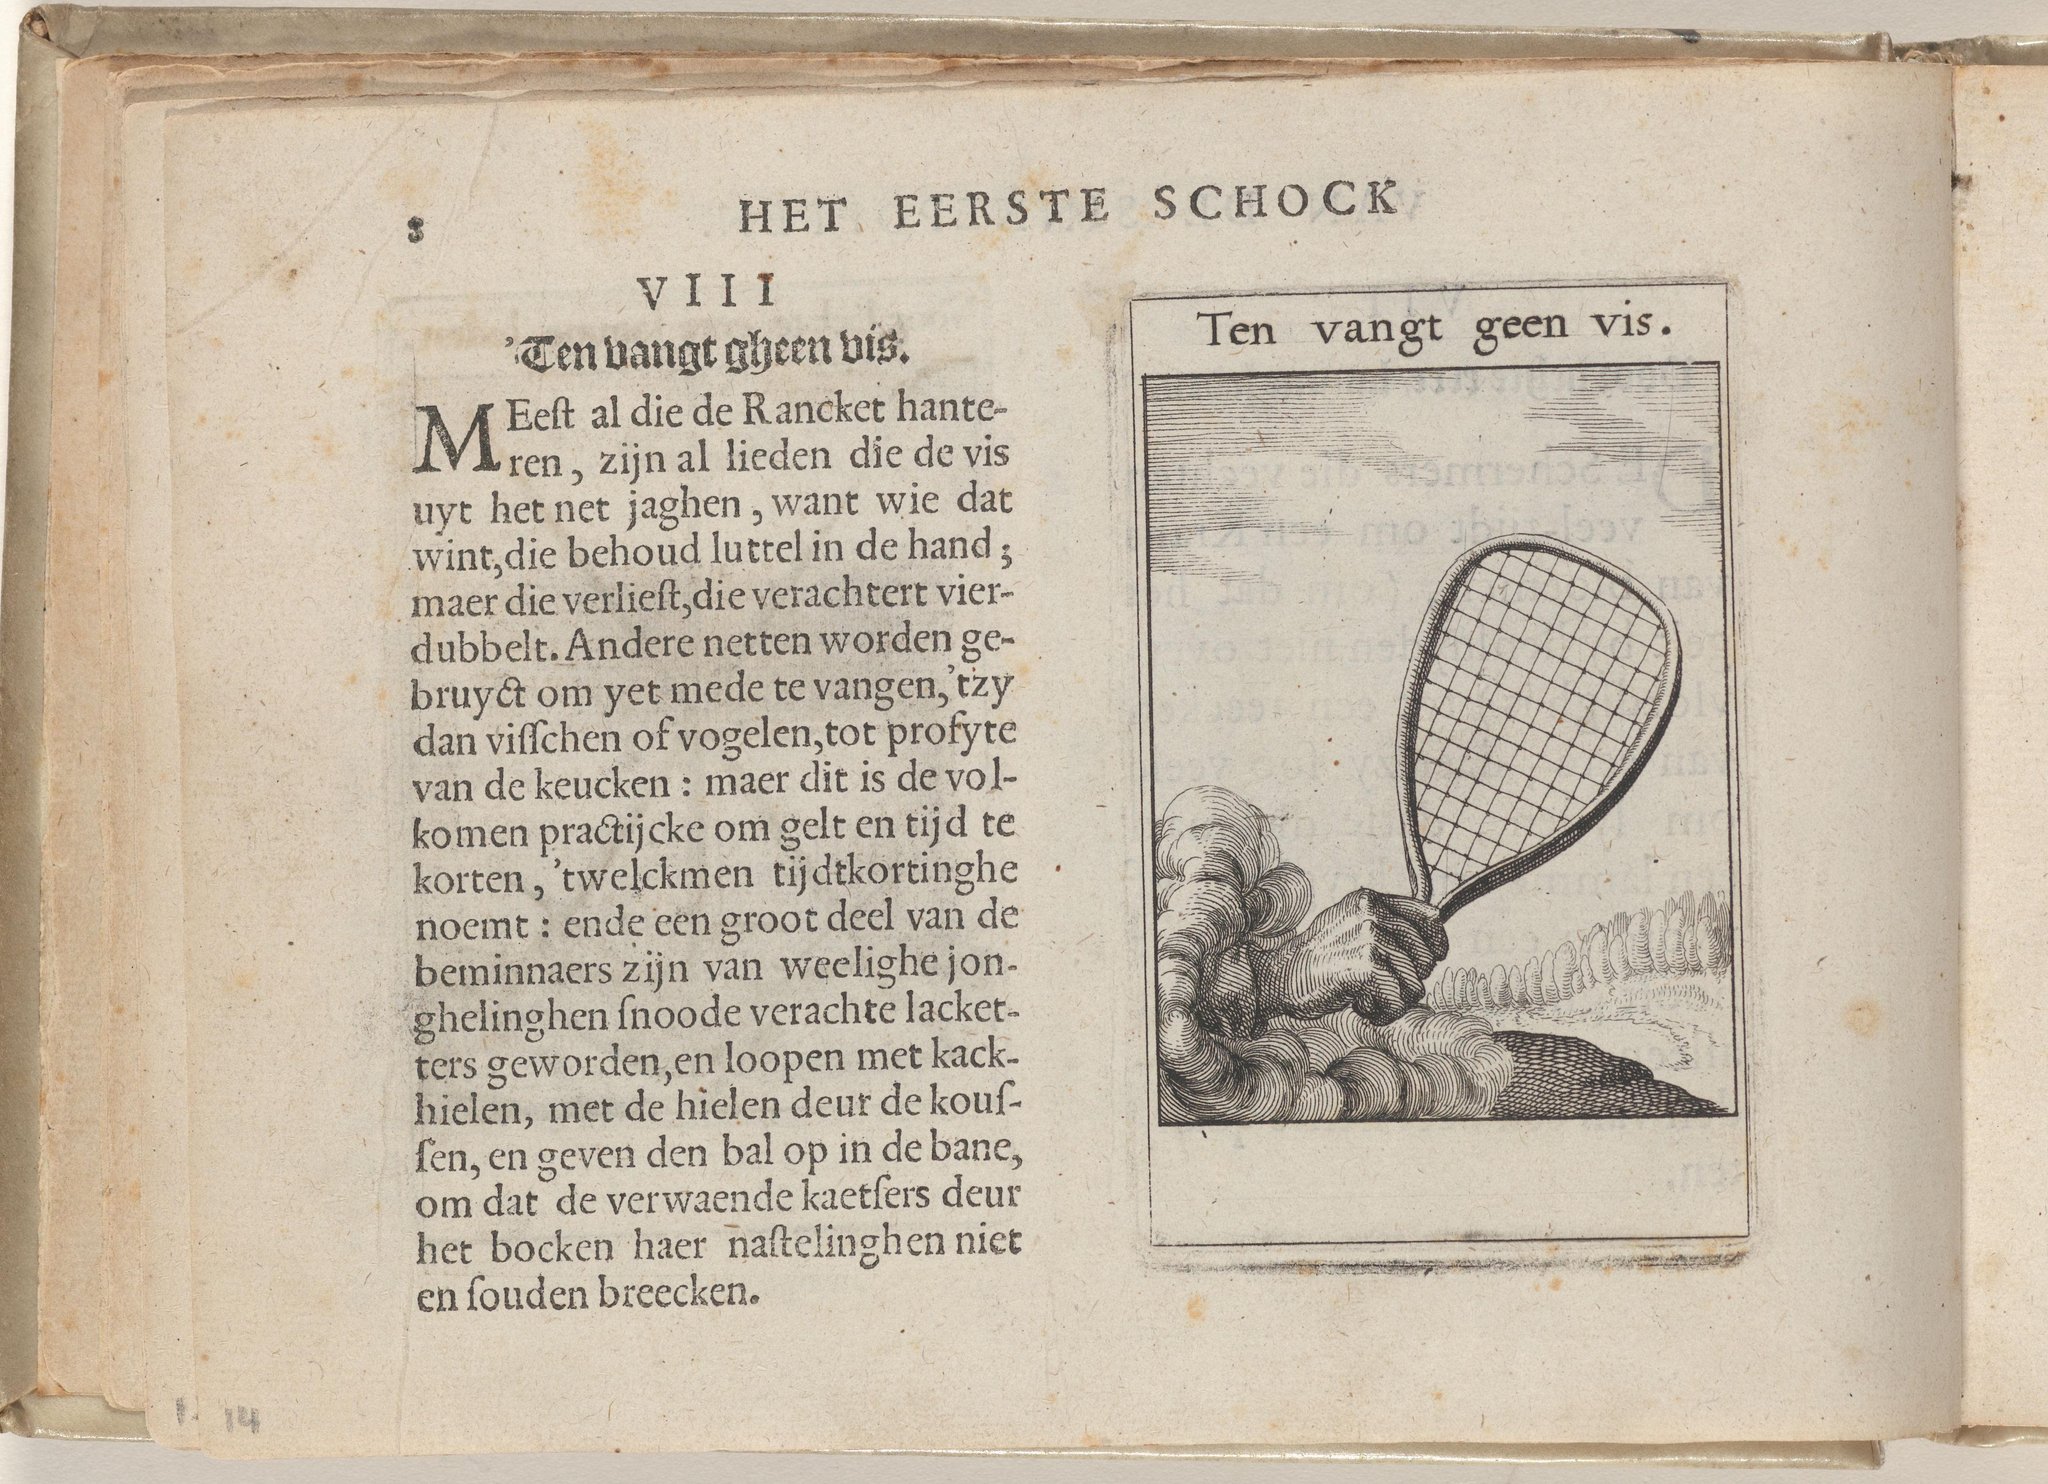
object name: print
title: VIII Ten vangt geen vis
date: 1614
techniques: engraving, printing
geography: the hague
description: VIII Ten vangt geen vis. Eerste schok. Onderdeel van 'Sinnepoppen', R. Visscher, 1614.